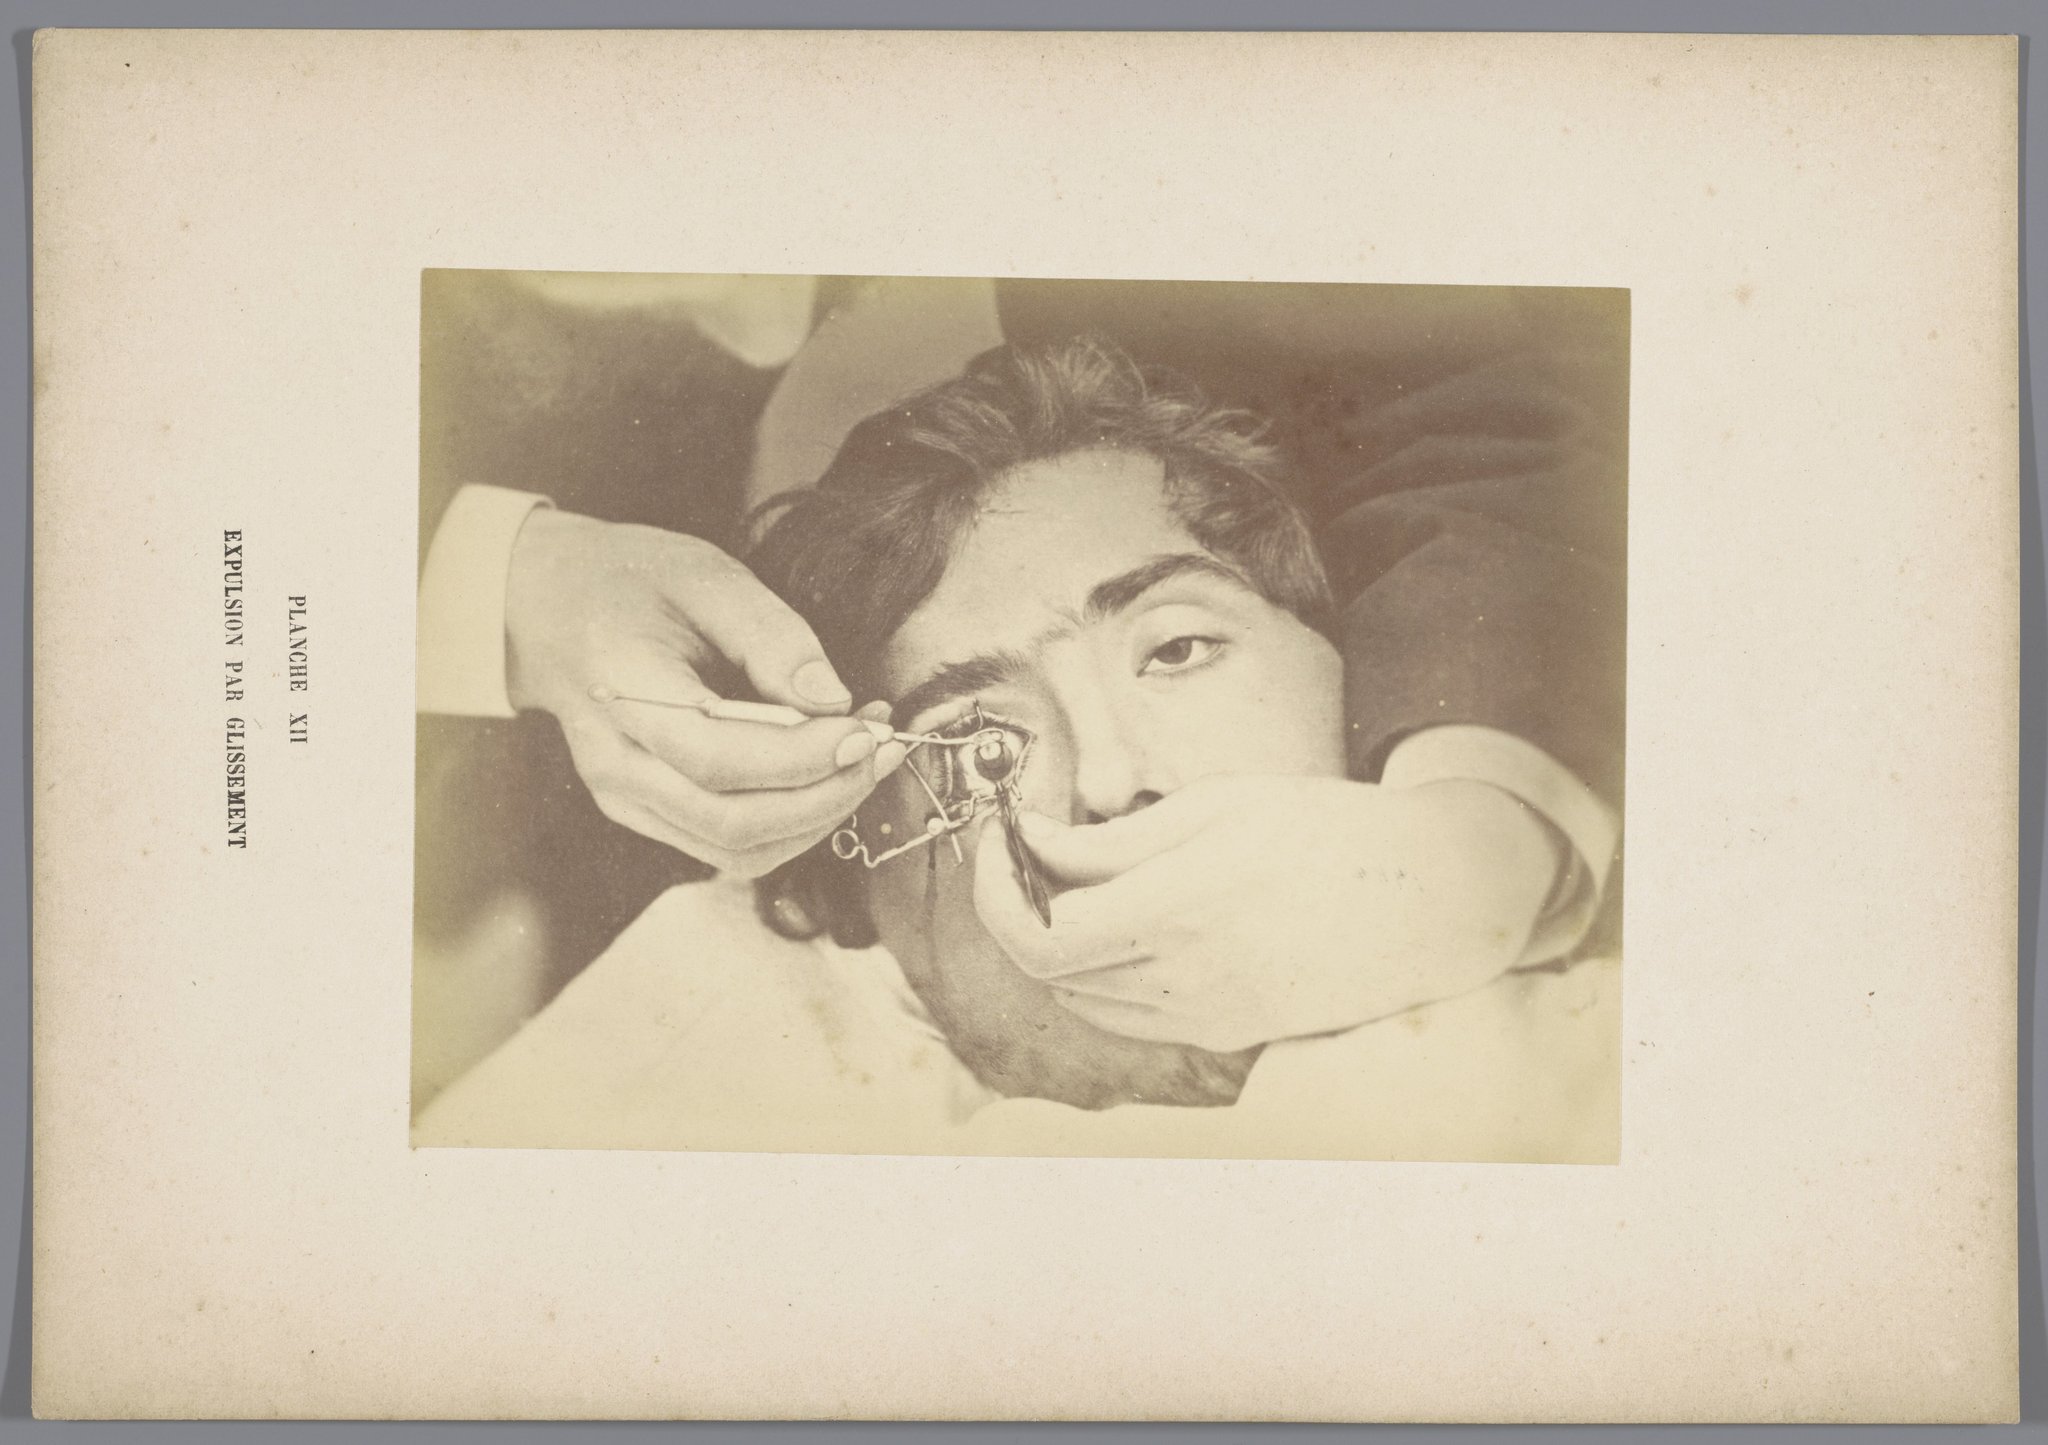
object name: page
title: Expulsion par glissement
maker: a. de montméja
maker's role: arts, fotograaf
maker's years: 1841-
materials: photographic support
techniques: albumen print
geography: france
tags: eyes, operation, surgery, disabilities affecting the eyes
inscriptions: number: ‘Planche XII’